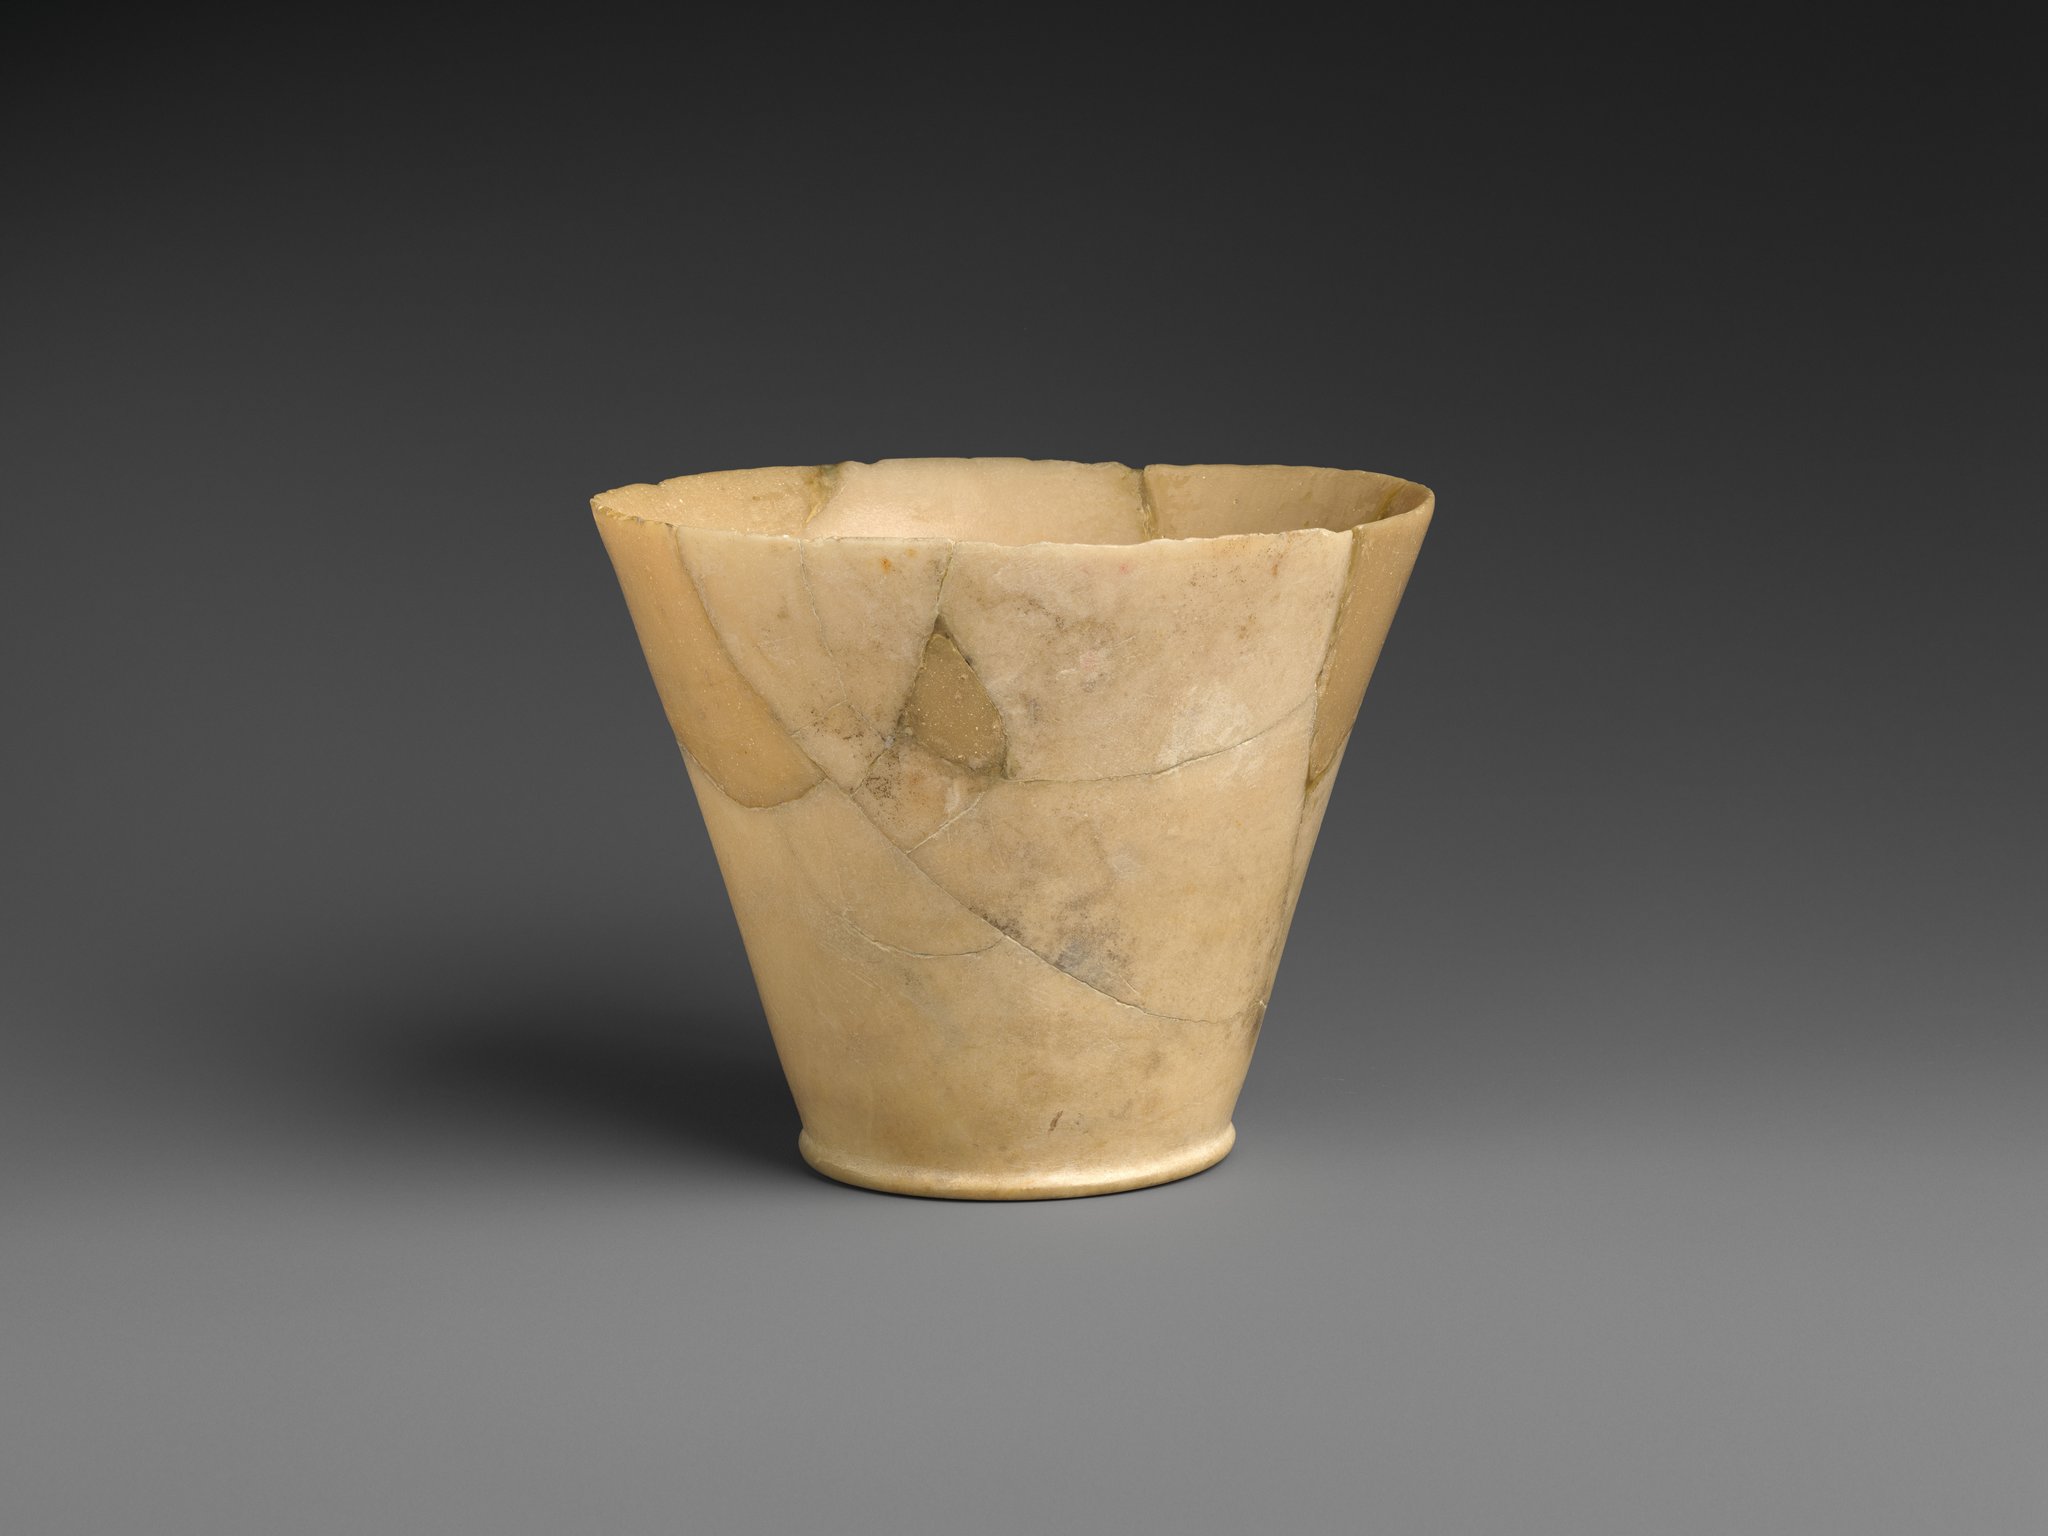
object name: cup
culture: sumerian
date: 2700-2600 BCE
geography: mesopotamia